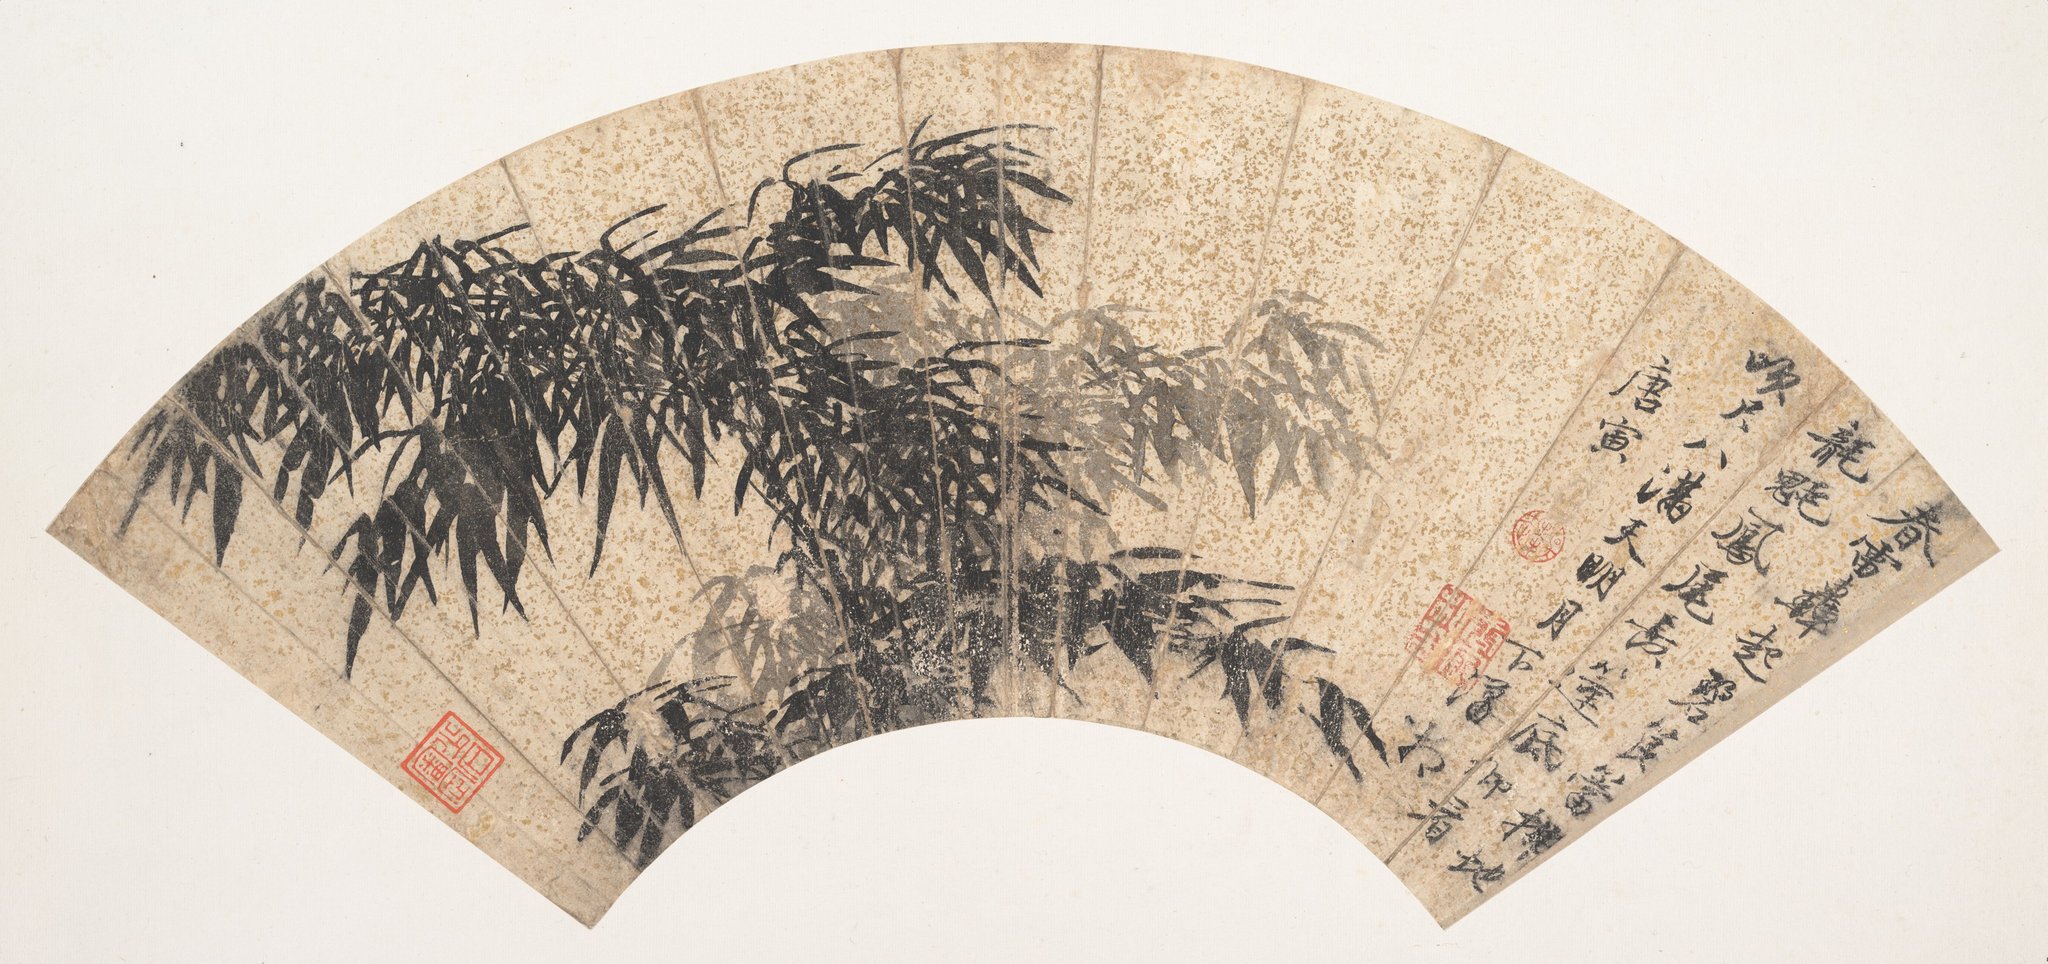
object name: folding fan mounted a an album leaf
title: Bamboo in a spring thunderstorm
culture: chinese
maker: tang yin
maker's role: artist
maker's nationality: chinese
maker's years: 1470-1524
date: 1601-1700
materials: gold, ink, paper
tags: bamboo